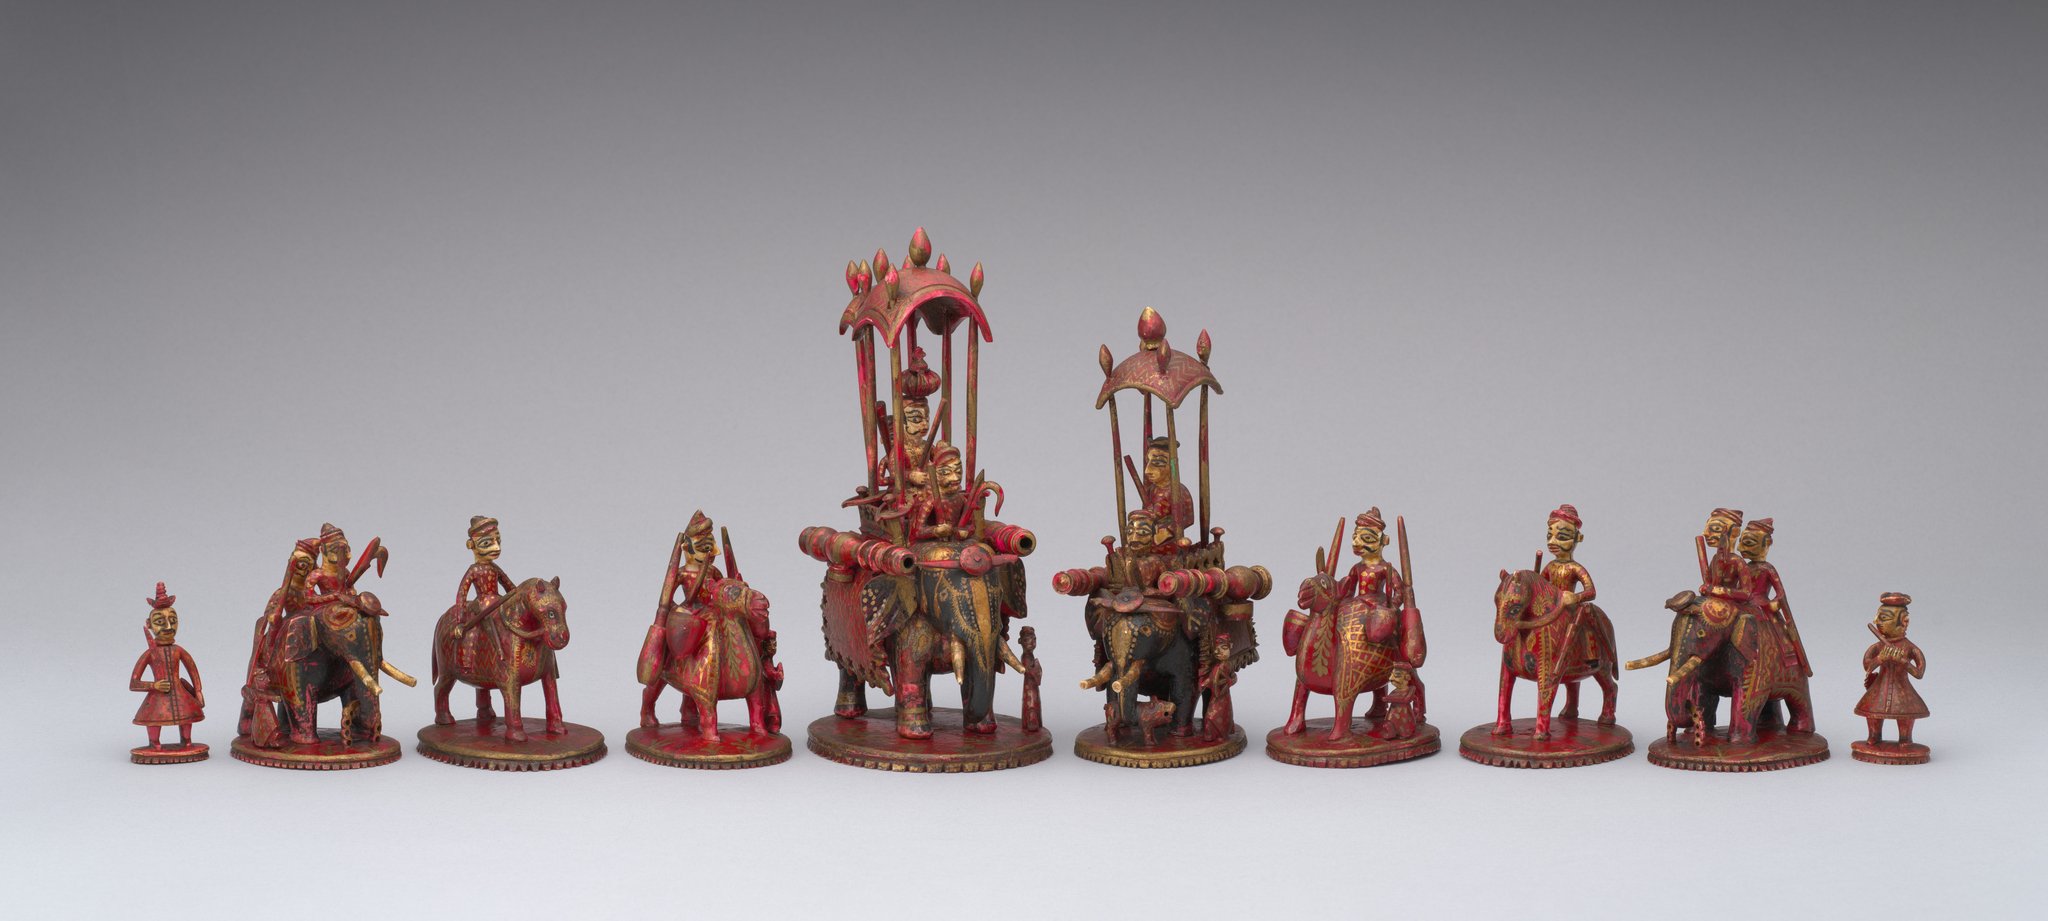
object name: chessman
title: Chessmen (32 pieces)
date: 1801-1900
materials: ivory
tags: chess,games